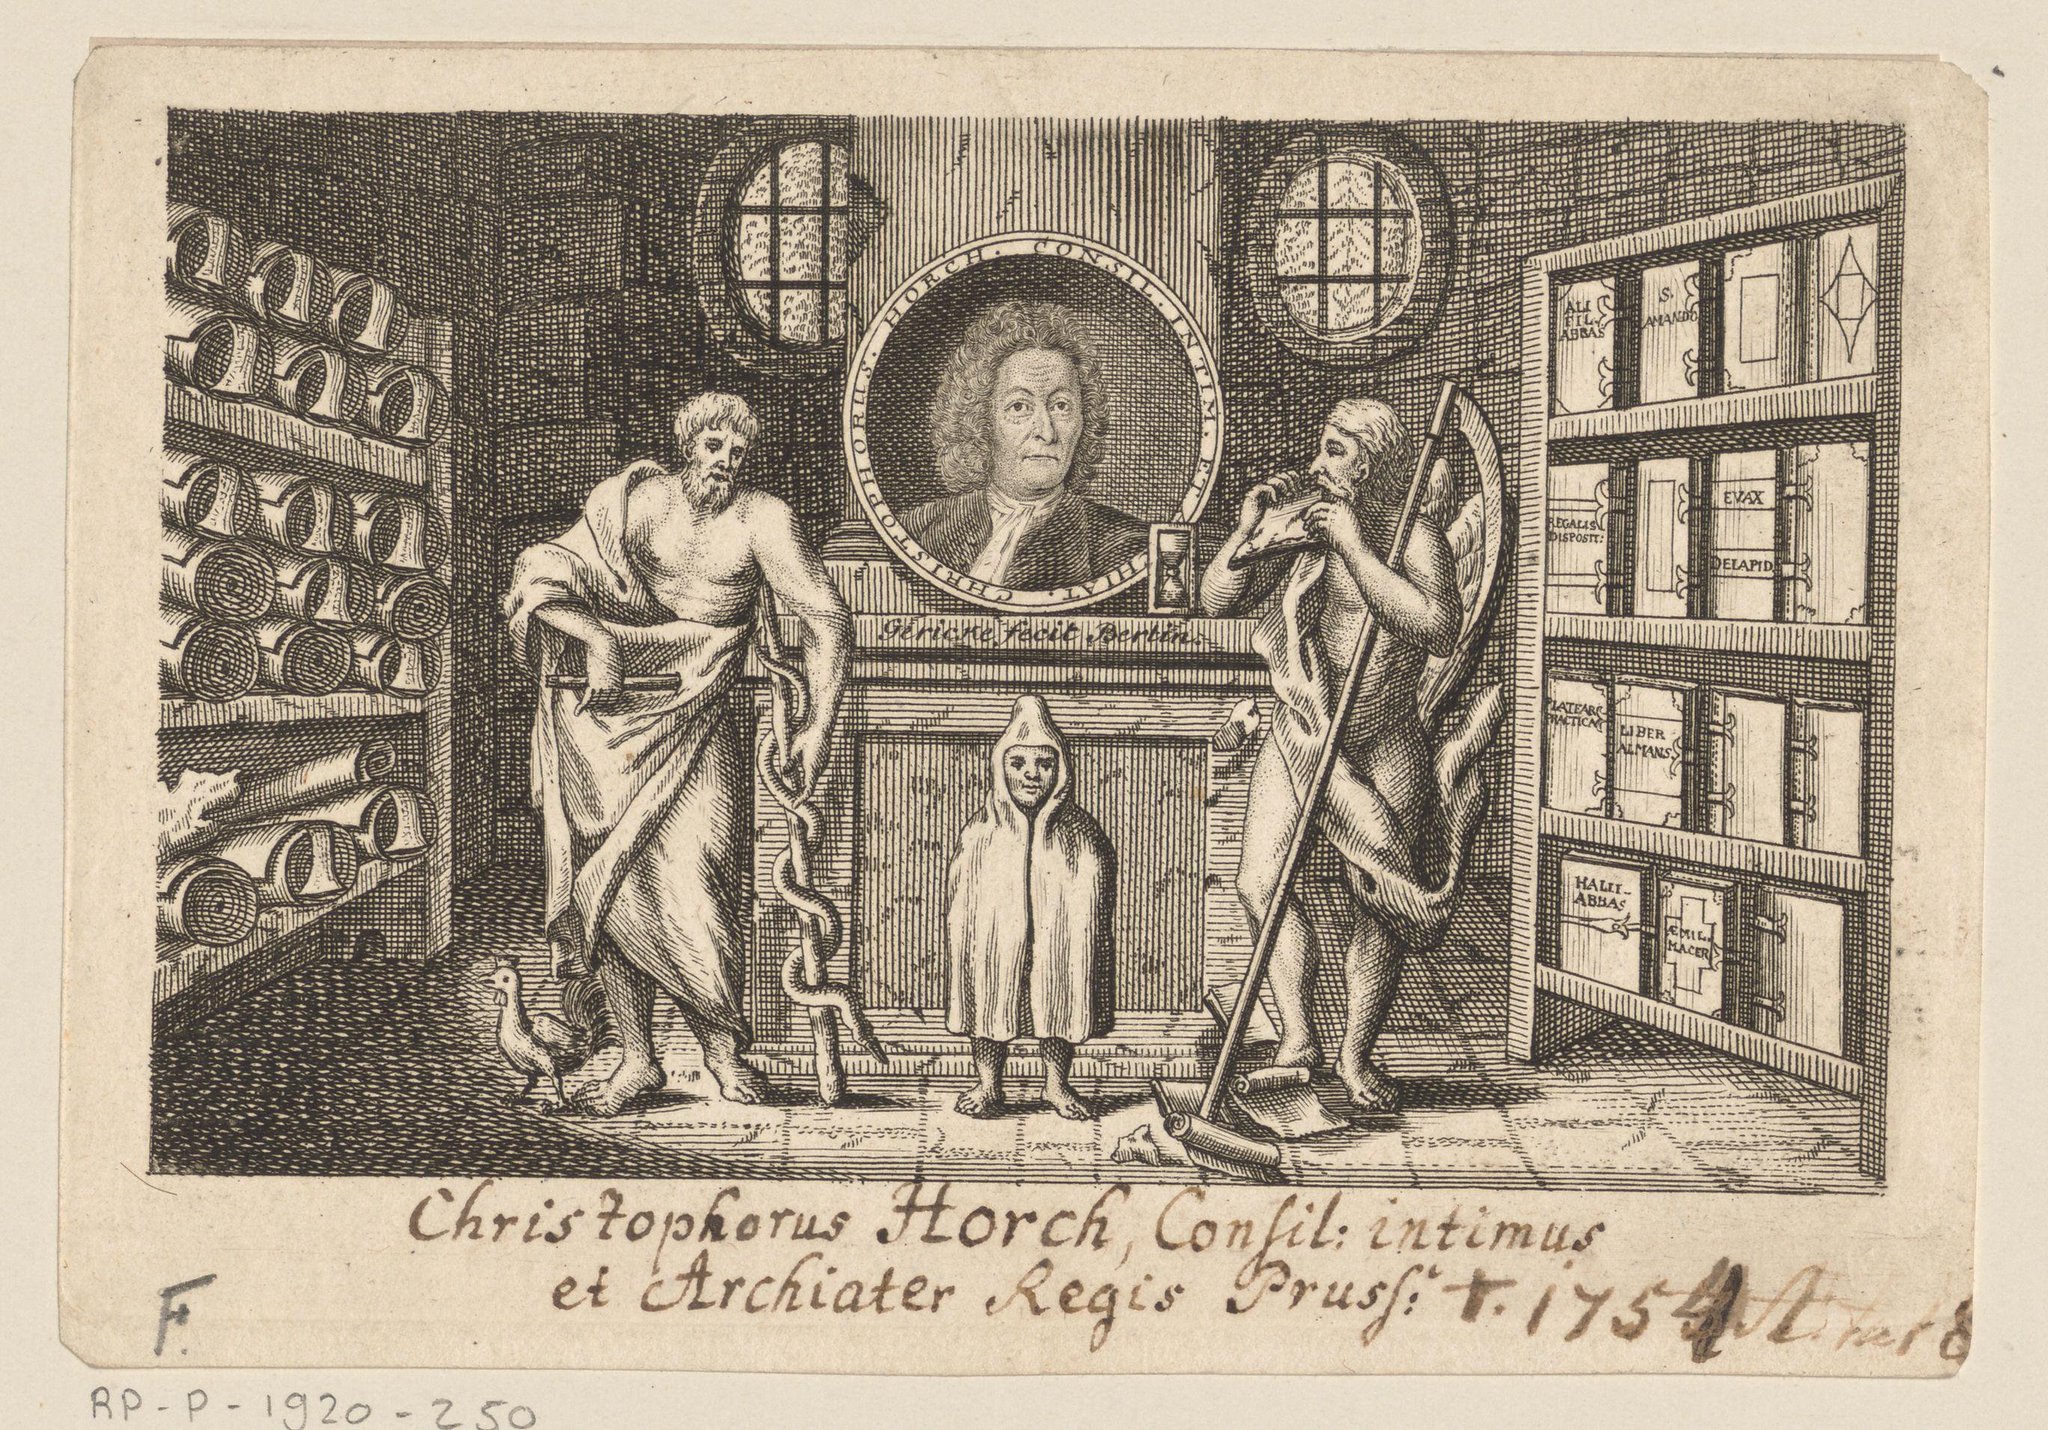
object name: print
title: Portret van Christoph Horch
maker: johann ernst gericke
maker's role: print maker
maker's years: 1726-1785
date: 1736-1785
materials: paper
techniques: engraving, etching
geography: berlin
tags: bookshelves, historical persons, physician, doctor, (story of) aesculapius (asclepius)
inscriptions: collector's mark: Lugt 2228, inscription: ‘Christophorus Horch Consil: intimus/ (...)’